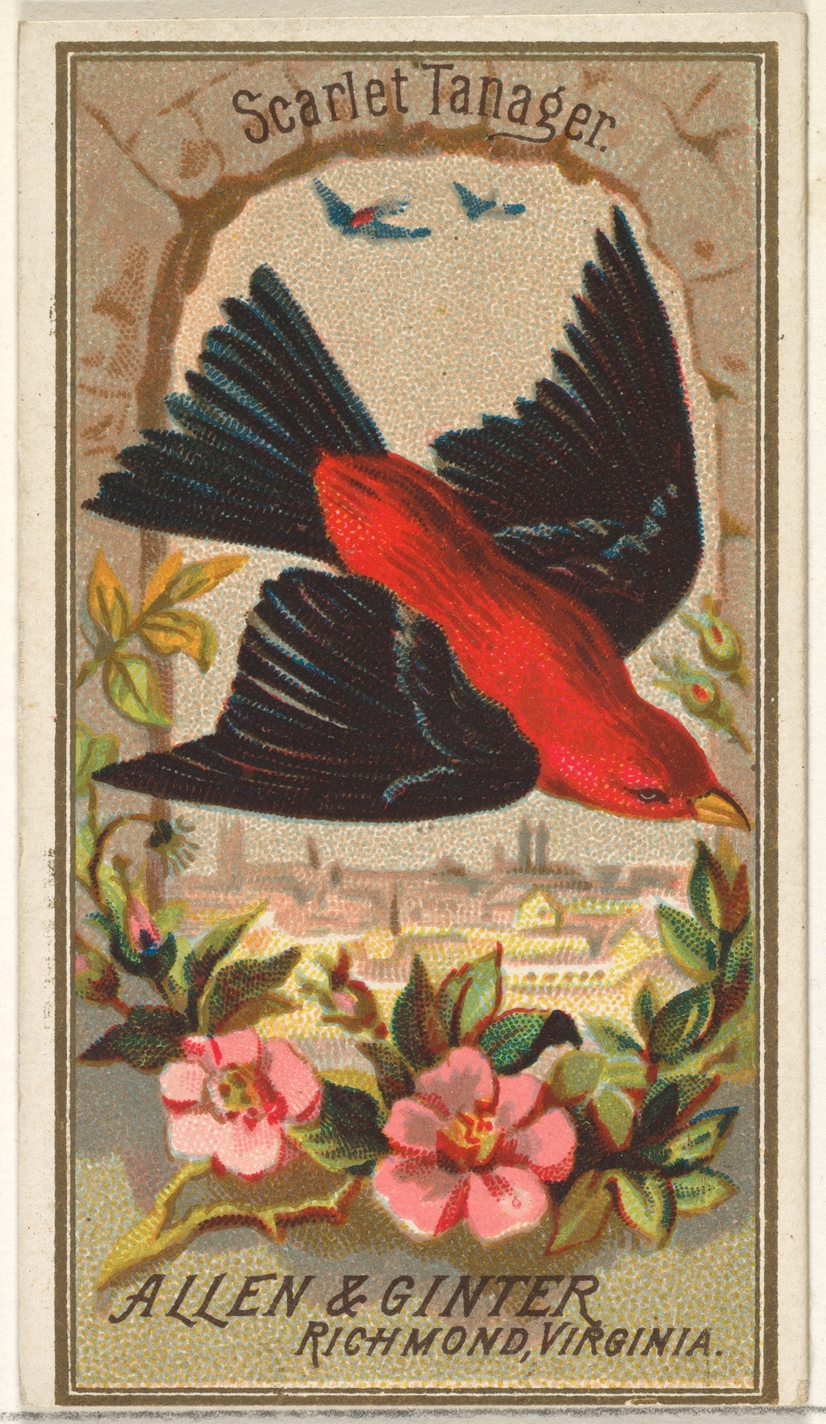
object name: print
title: Scarlet Tanager, from the Birds of America series (N4) for Allen & Ginter Cigarettes Brands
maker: allen & ginter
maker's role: publisher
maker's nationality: american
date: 1888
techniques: color lithograph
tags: birds